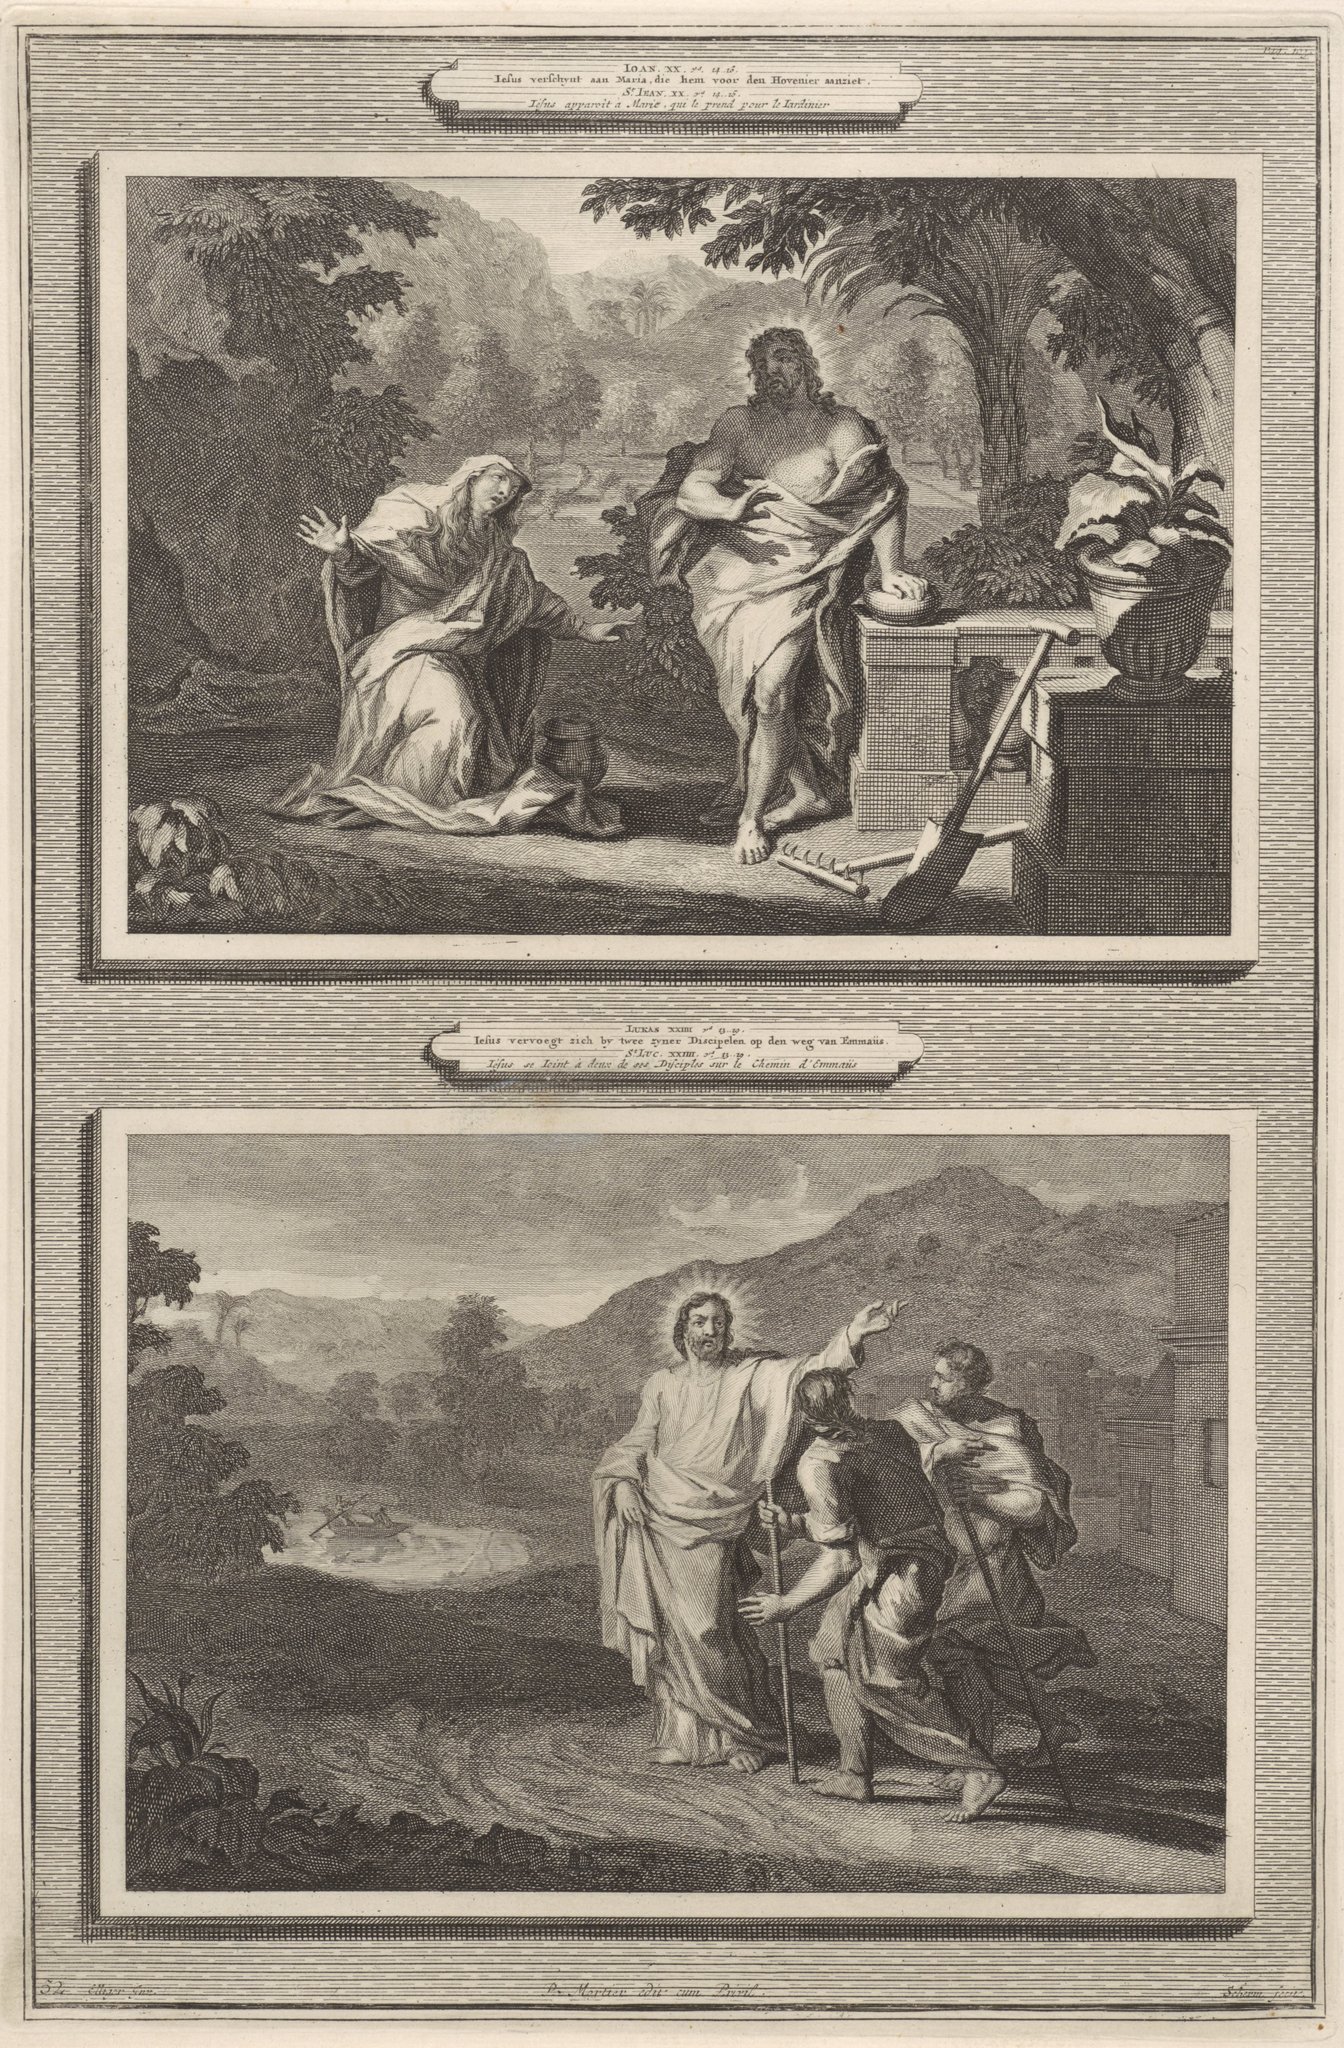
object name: print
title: Iesus verschynt aan Maria, die hem voor den Hovenier aanziet / Iesus vervoegt sich by twee zyner Discipelen op den weg van Emmaüs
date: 1700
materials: paper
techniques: engraving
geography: amsterdam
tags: mary magdalene kneeling before christ, who is usually represented as a gardener with a hoe and/or a spade; 'noli me tangere', title-page, cleopas and peter meet christ (sometimes they are dressed as pilgrims)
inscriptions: collector's mark: Lugt 2228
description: Twee verschijningen van Christus na de opstanding. Boven verschijnt hij aan Maria Magdalena, die voor hem knielt. Rechts vooraan is tuingereedschap te zien, omdat Maria dacht dat Christus de tuinman was. Onder staat hij voor de Emmaüsgangers Cleopas en Petrus. Linksonder: 52.